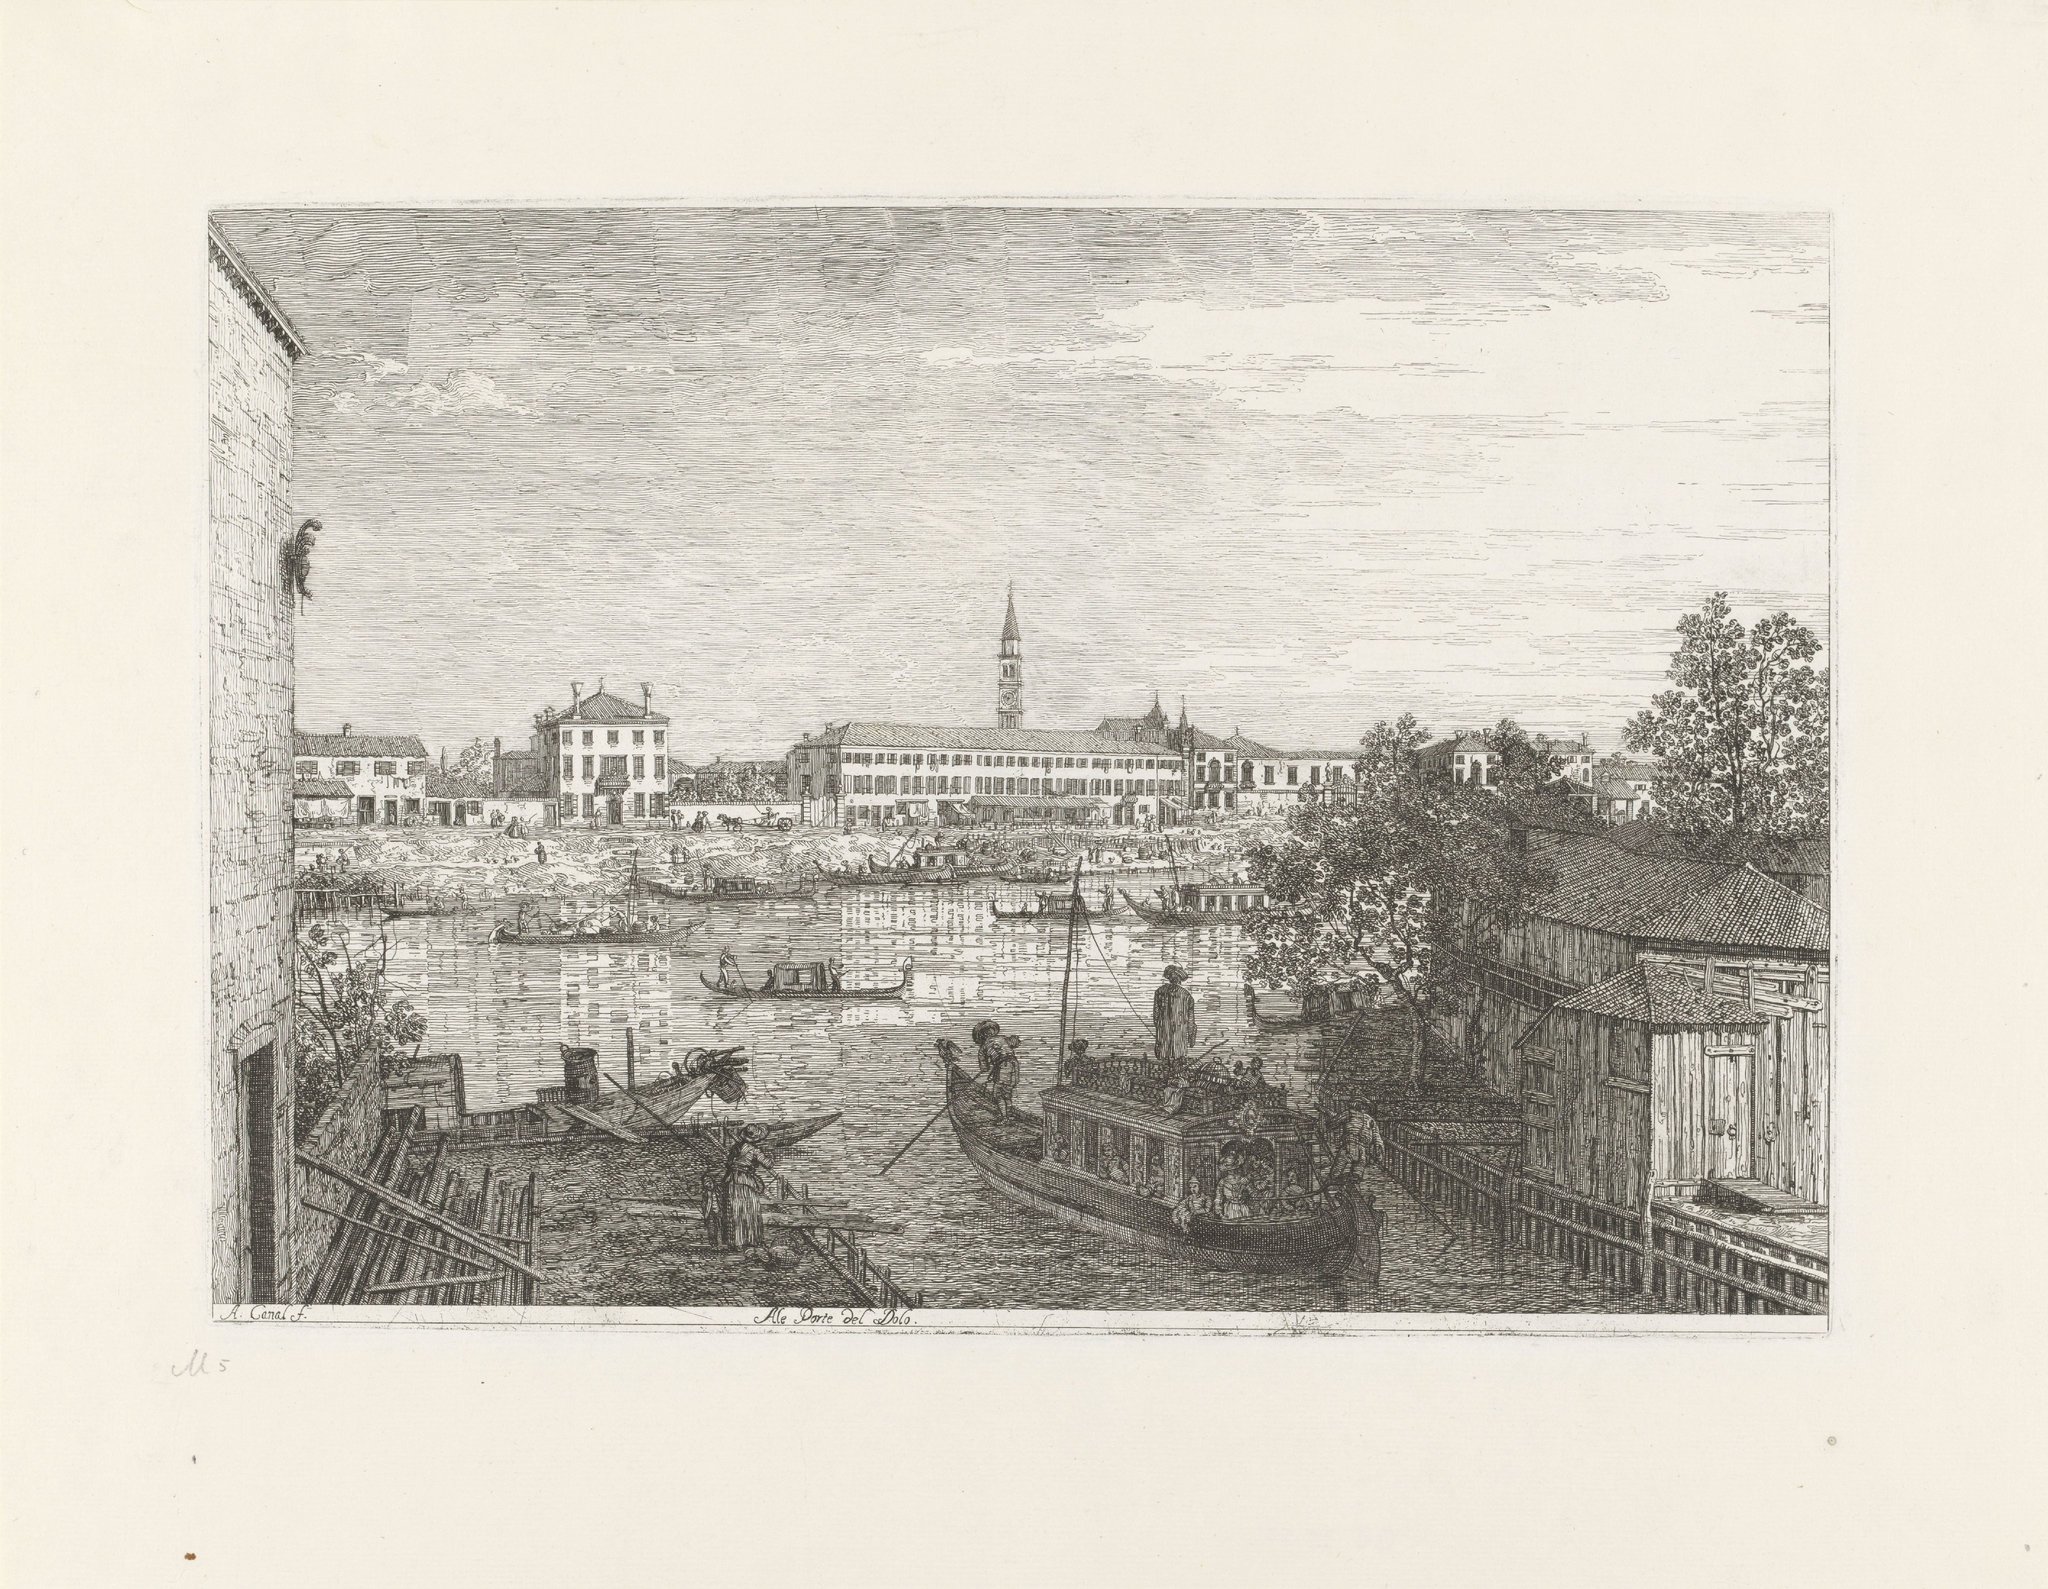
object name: print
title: Gezichten op bestaande en verzonnen plaatsen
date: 1707-1768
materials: paper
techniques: etching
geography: venice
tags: harbour, city-view, and landscape with man-made constructions, river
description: Een aanlegplaats voor schepen te Dolo. Verschillende schepen liggen in het water. Op de achtergrond de klokkentoren van de Duomo di Dolo (San Rocco).